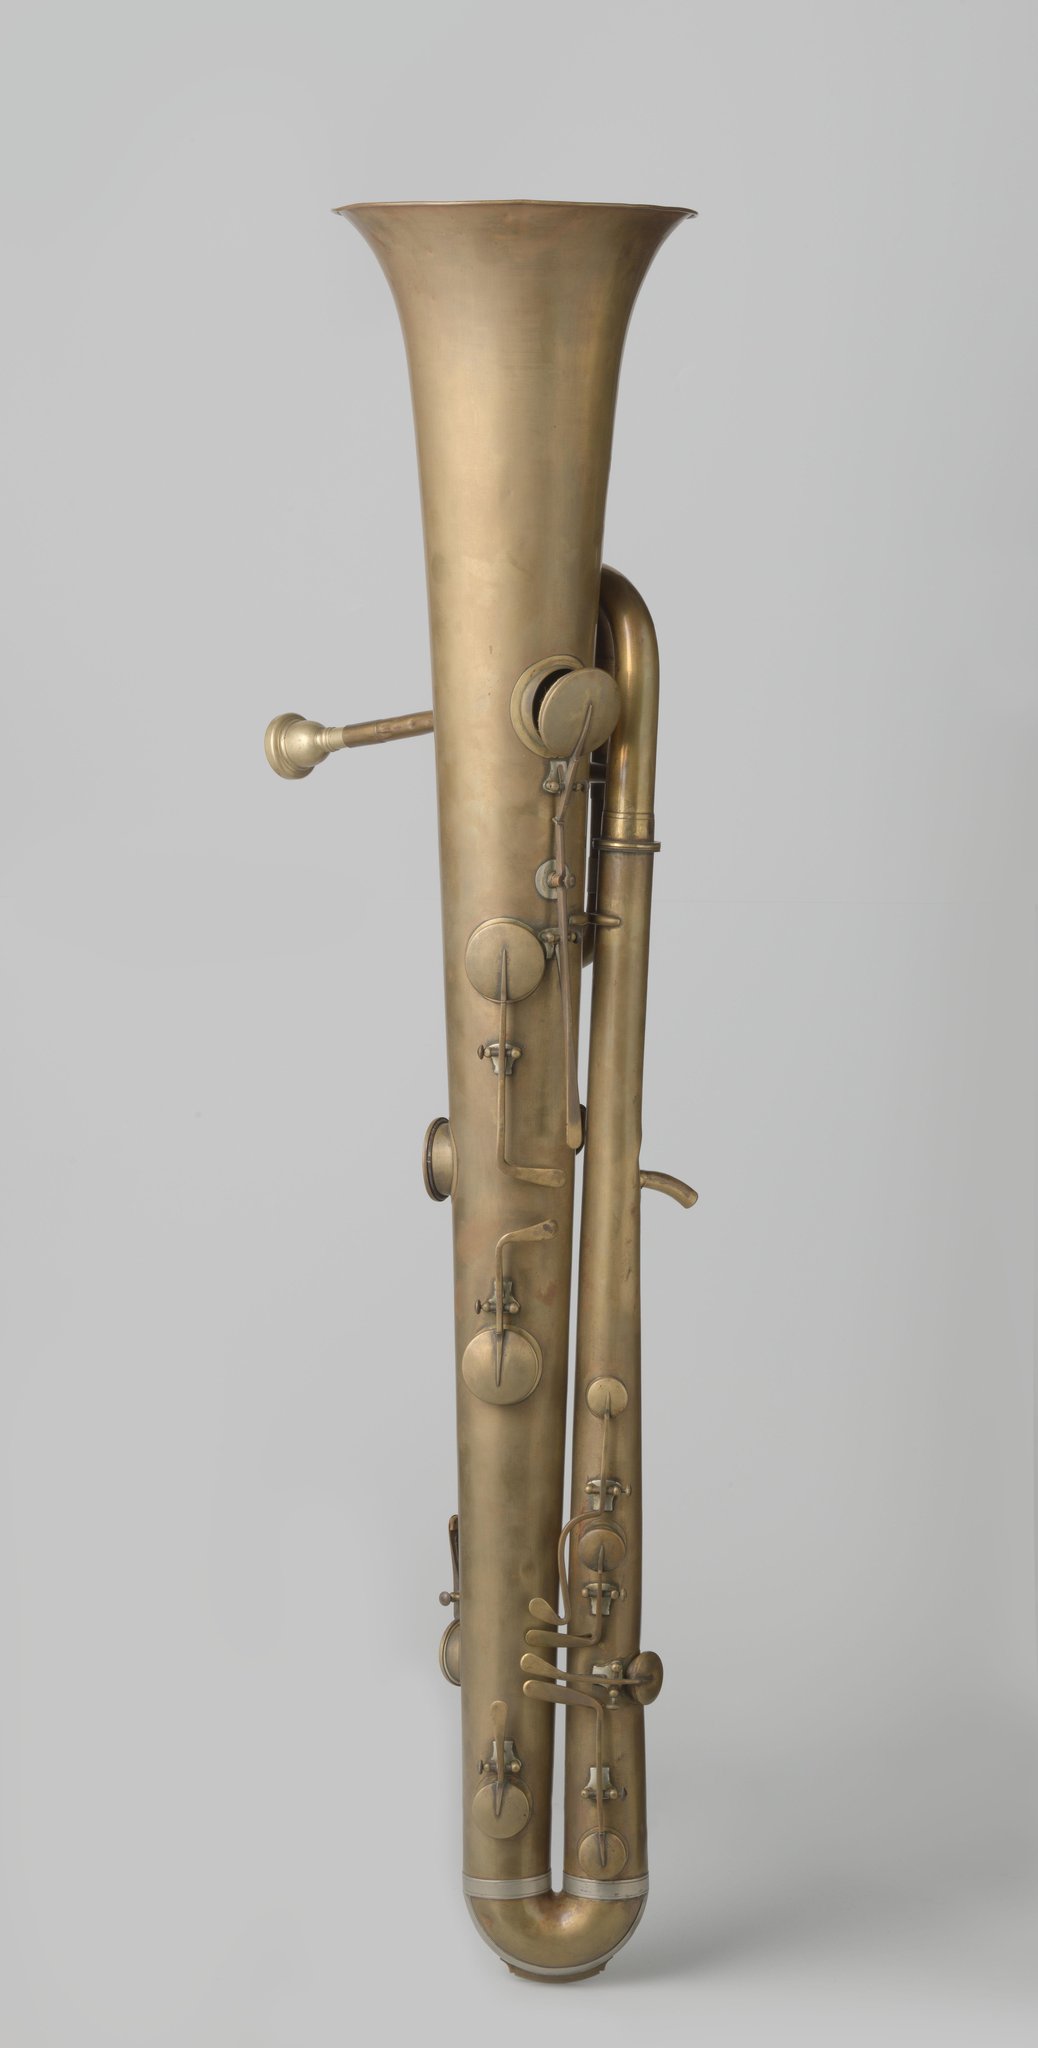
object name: ophicleide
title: Bass ophicleide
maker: Anonymous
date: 1830-1850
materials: copper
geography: france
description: Music has always been a crucial element of public celebrations, such as military parades, coronations, royal weddings, and funerals, adding grandeur to the solemnity of the occasion. Musical ensembles entrusted with performing music at these events have existed in Europe since the Middle Ages. This display highlights various marching bands and their musical instruments dating from the 16th to the 19th century.